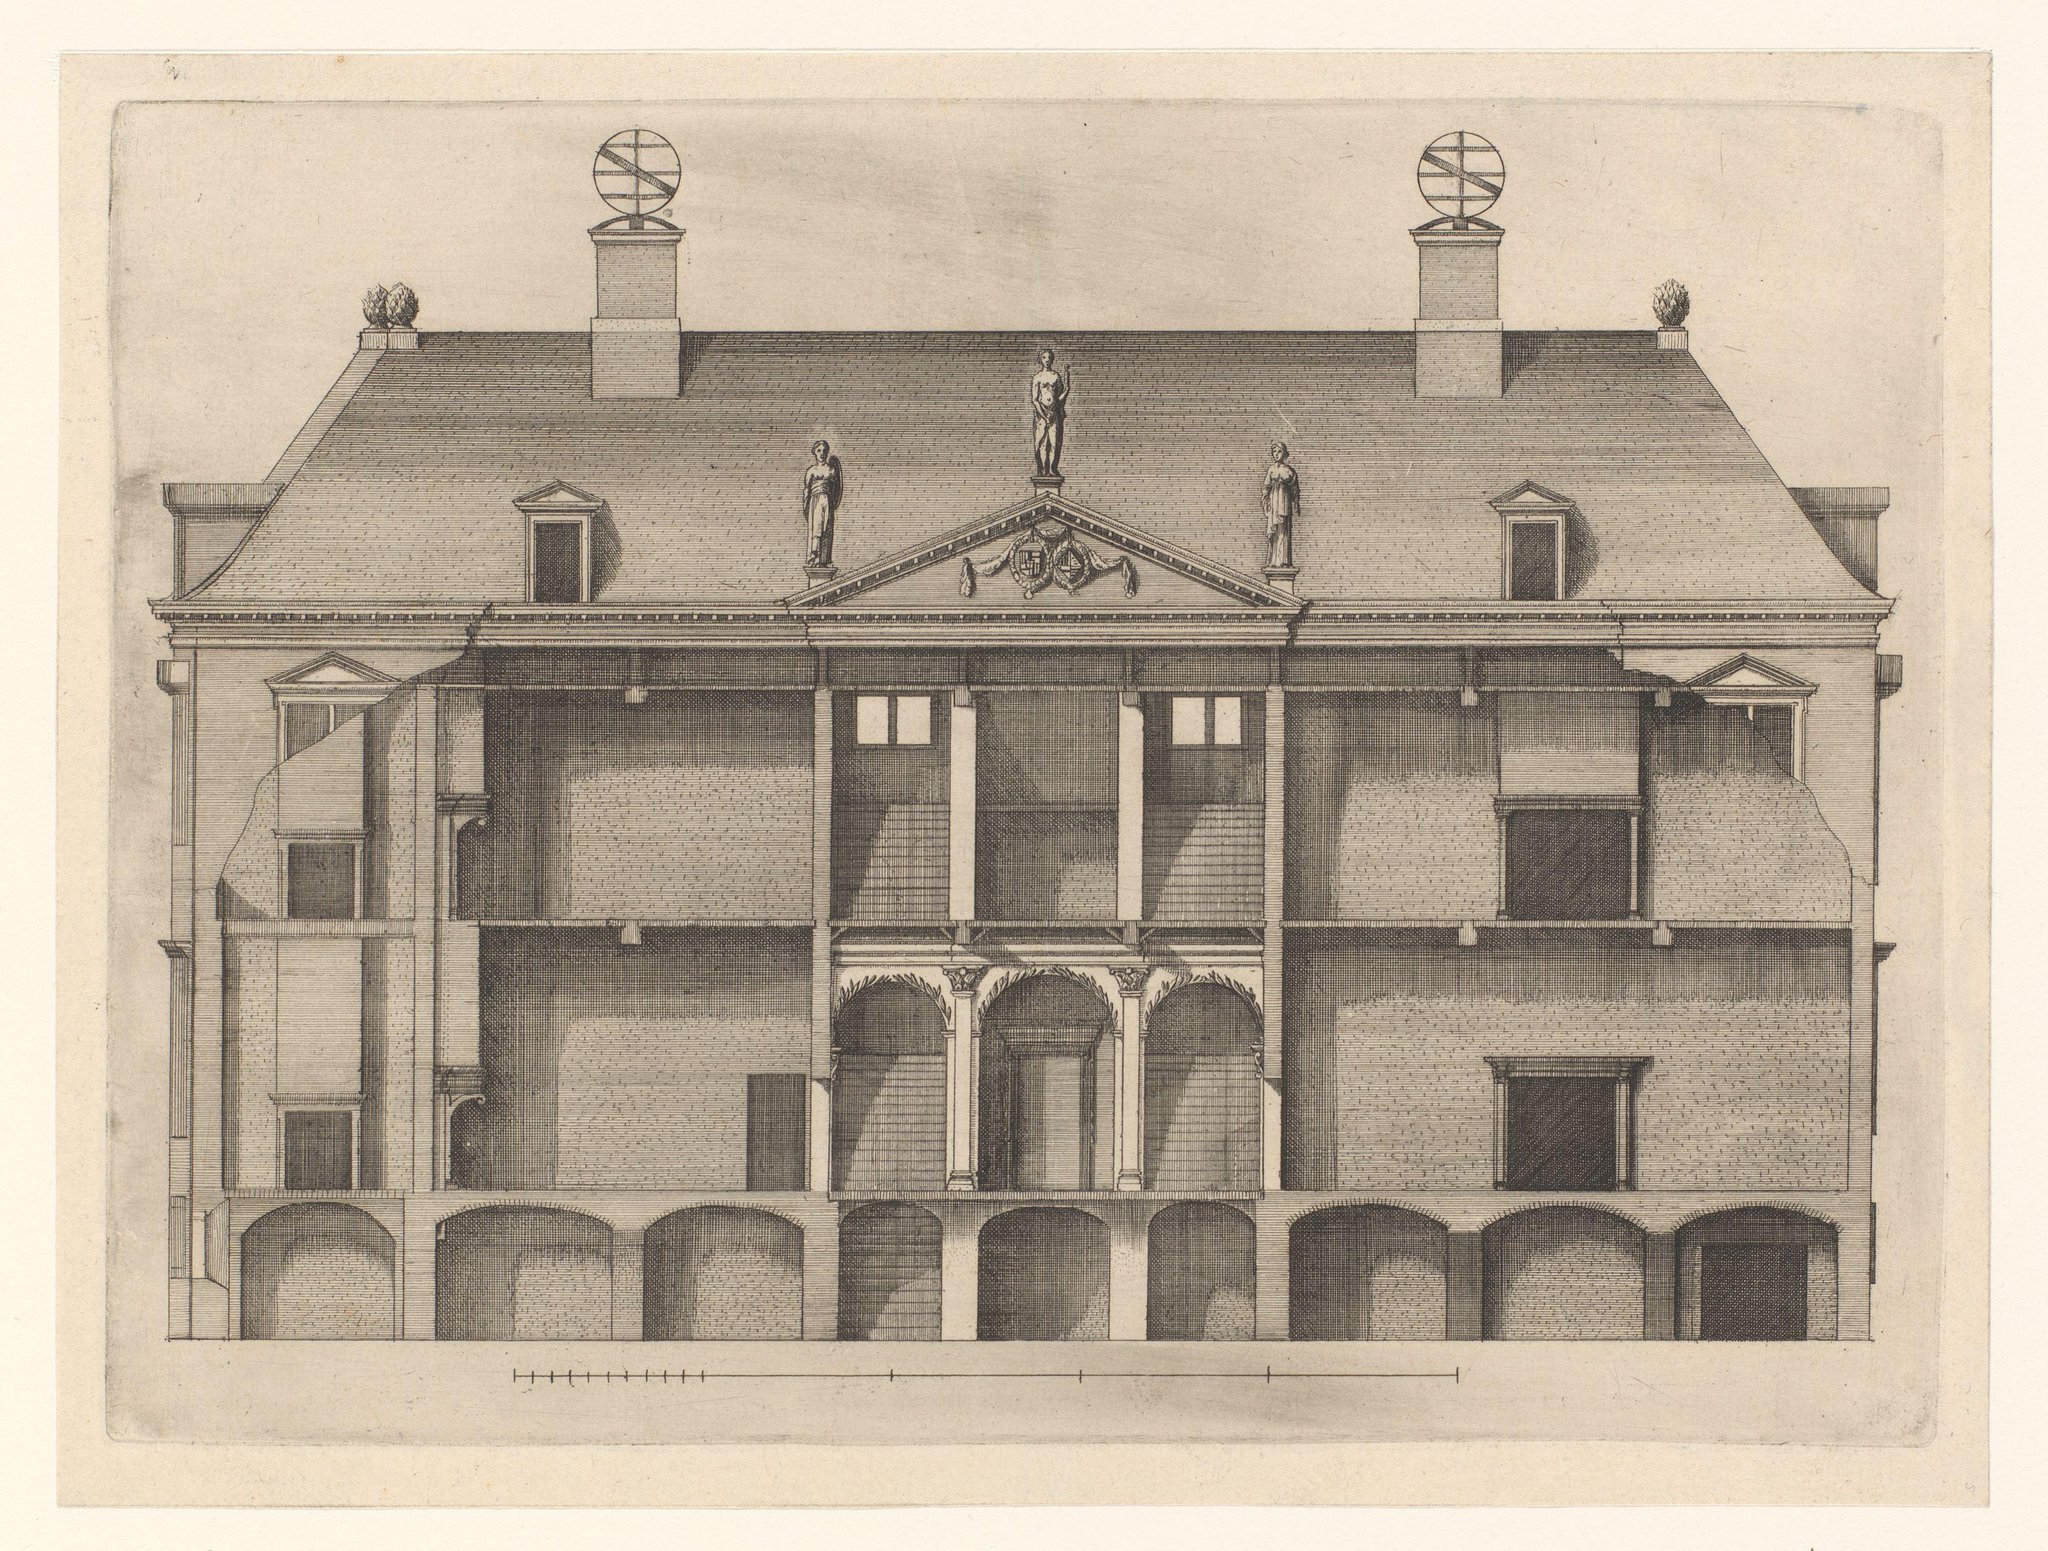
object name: print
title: Huis van Constantijn Huygens van voren gezien met deel van het interieur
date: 1639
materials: paper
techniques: etching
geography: the hague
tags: constantijn huygens (i), interior of the house, façade (of house or building), armorial bearing, heraldry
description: Het huis van voren gezien, met een deel van de gevel weggelaten waardoor het interieur te zien is.